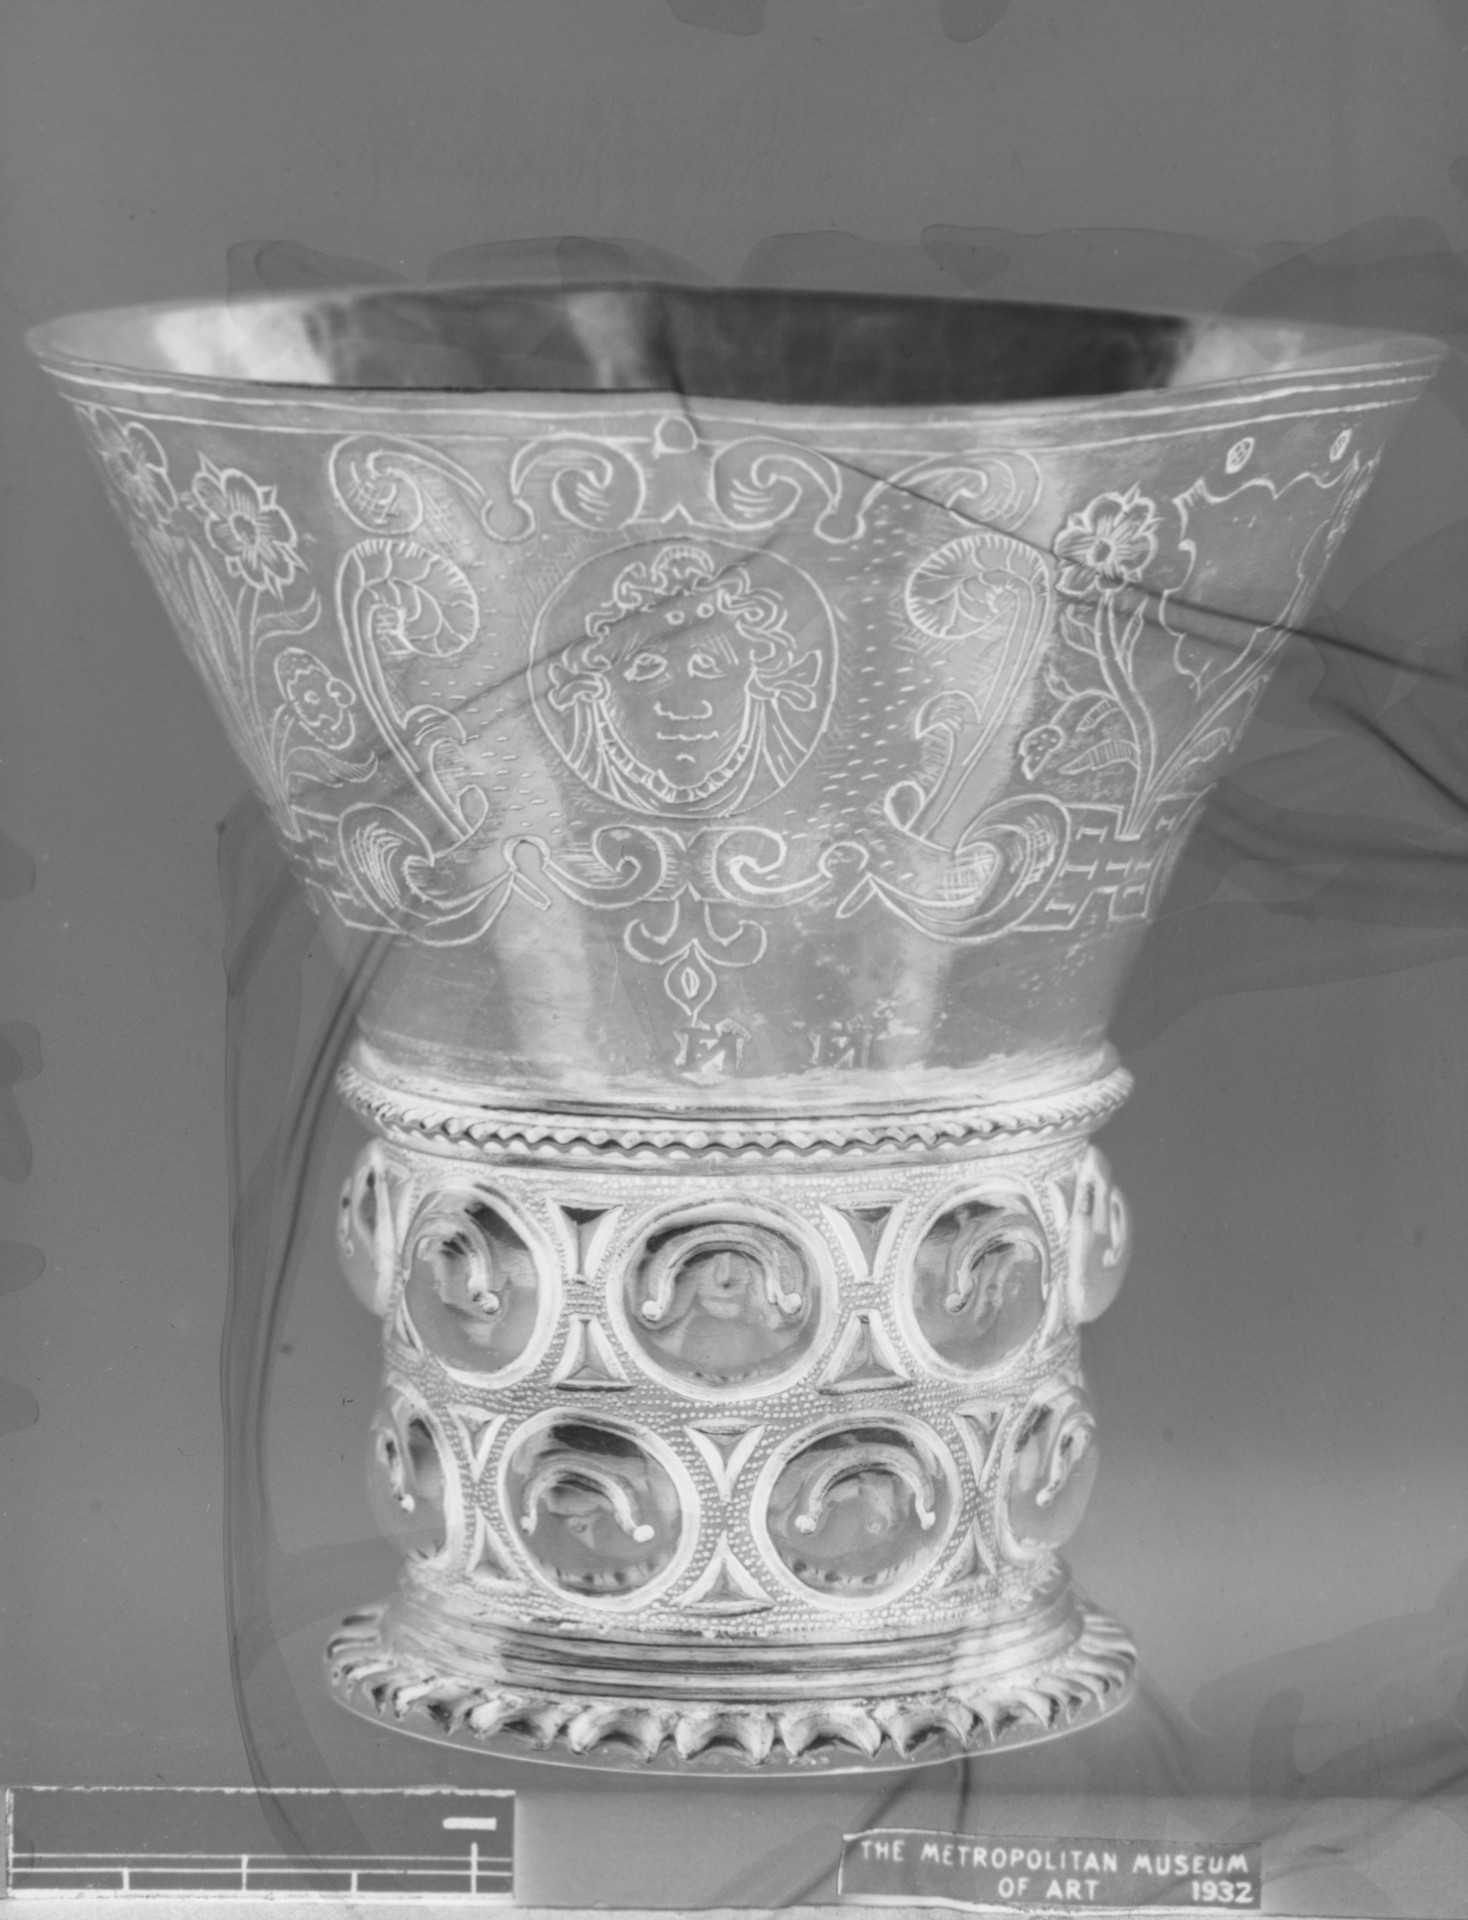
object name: beaker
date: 1601-1700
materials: gilt, silver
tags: faces